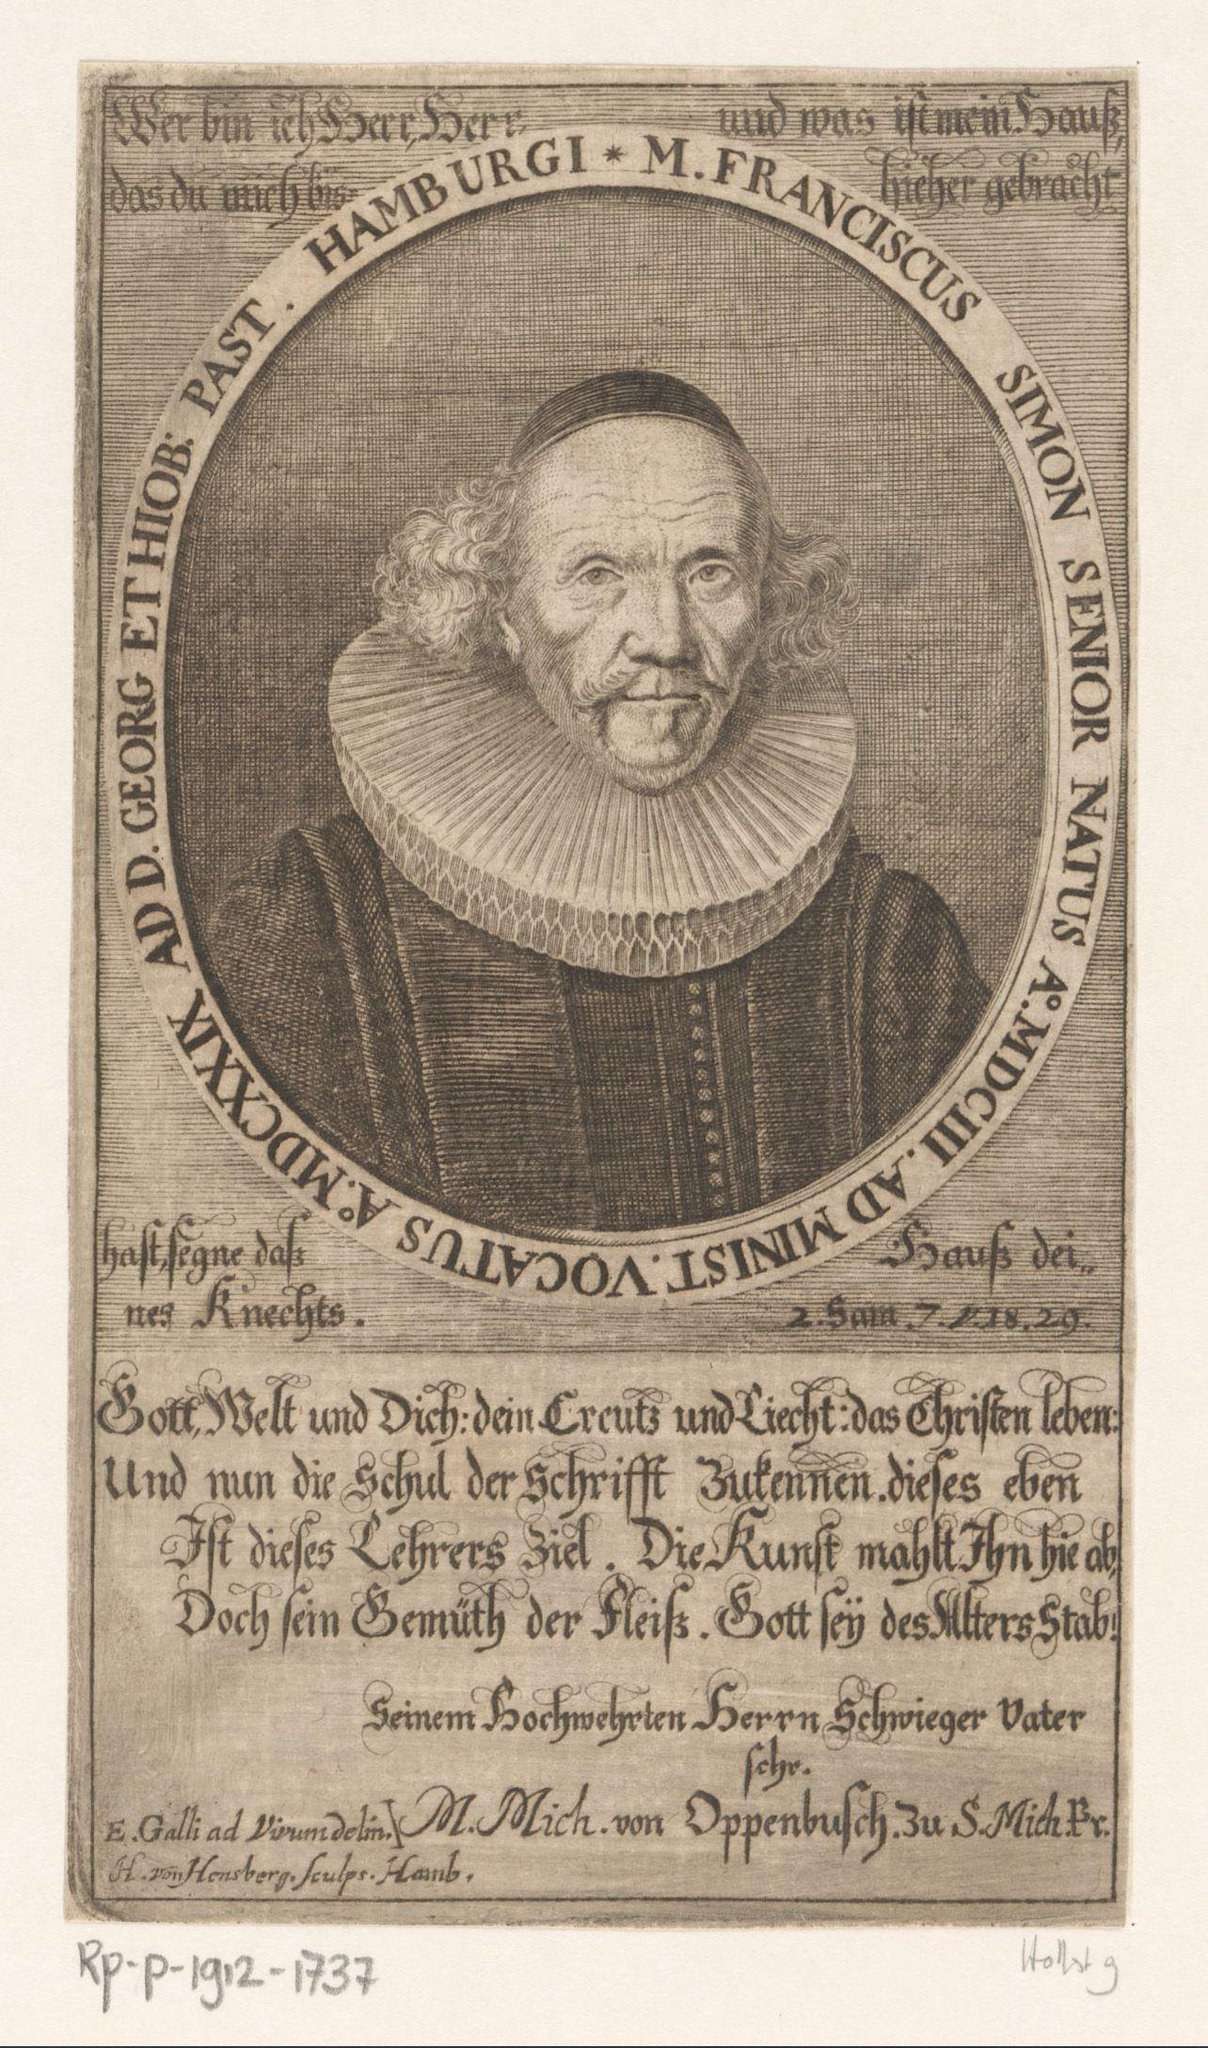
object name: print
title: Portret van Franz Simon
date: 1660-1690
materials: paper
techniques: engraving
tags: theologian, historical persons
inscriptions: collector's mark: Lugt 2228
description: Met vier regels onderschrift in het Duits.